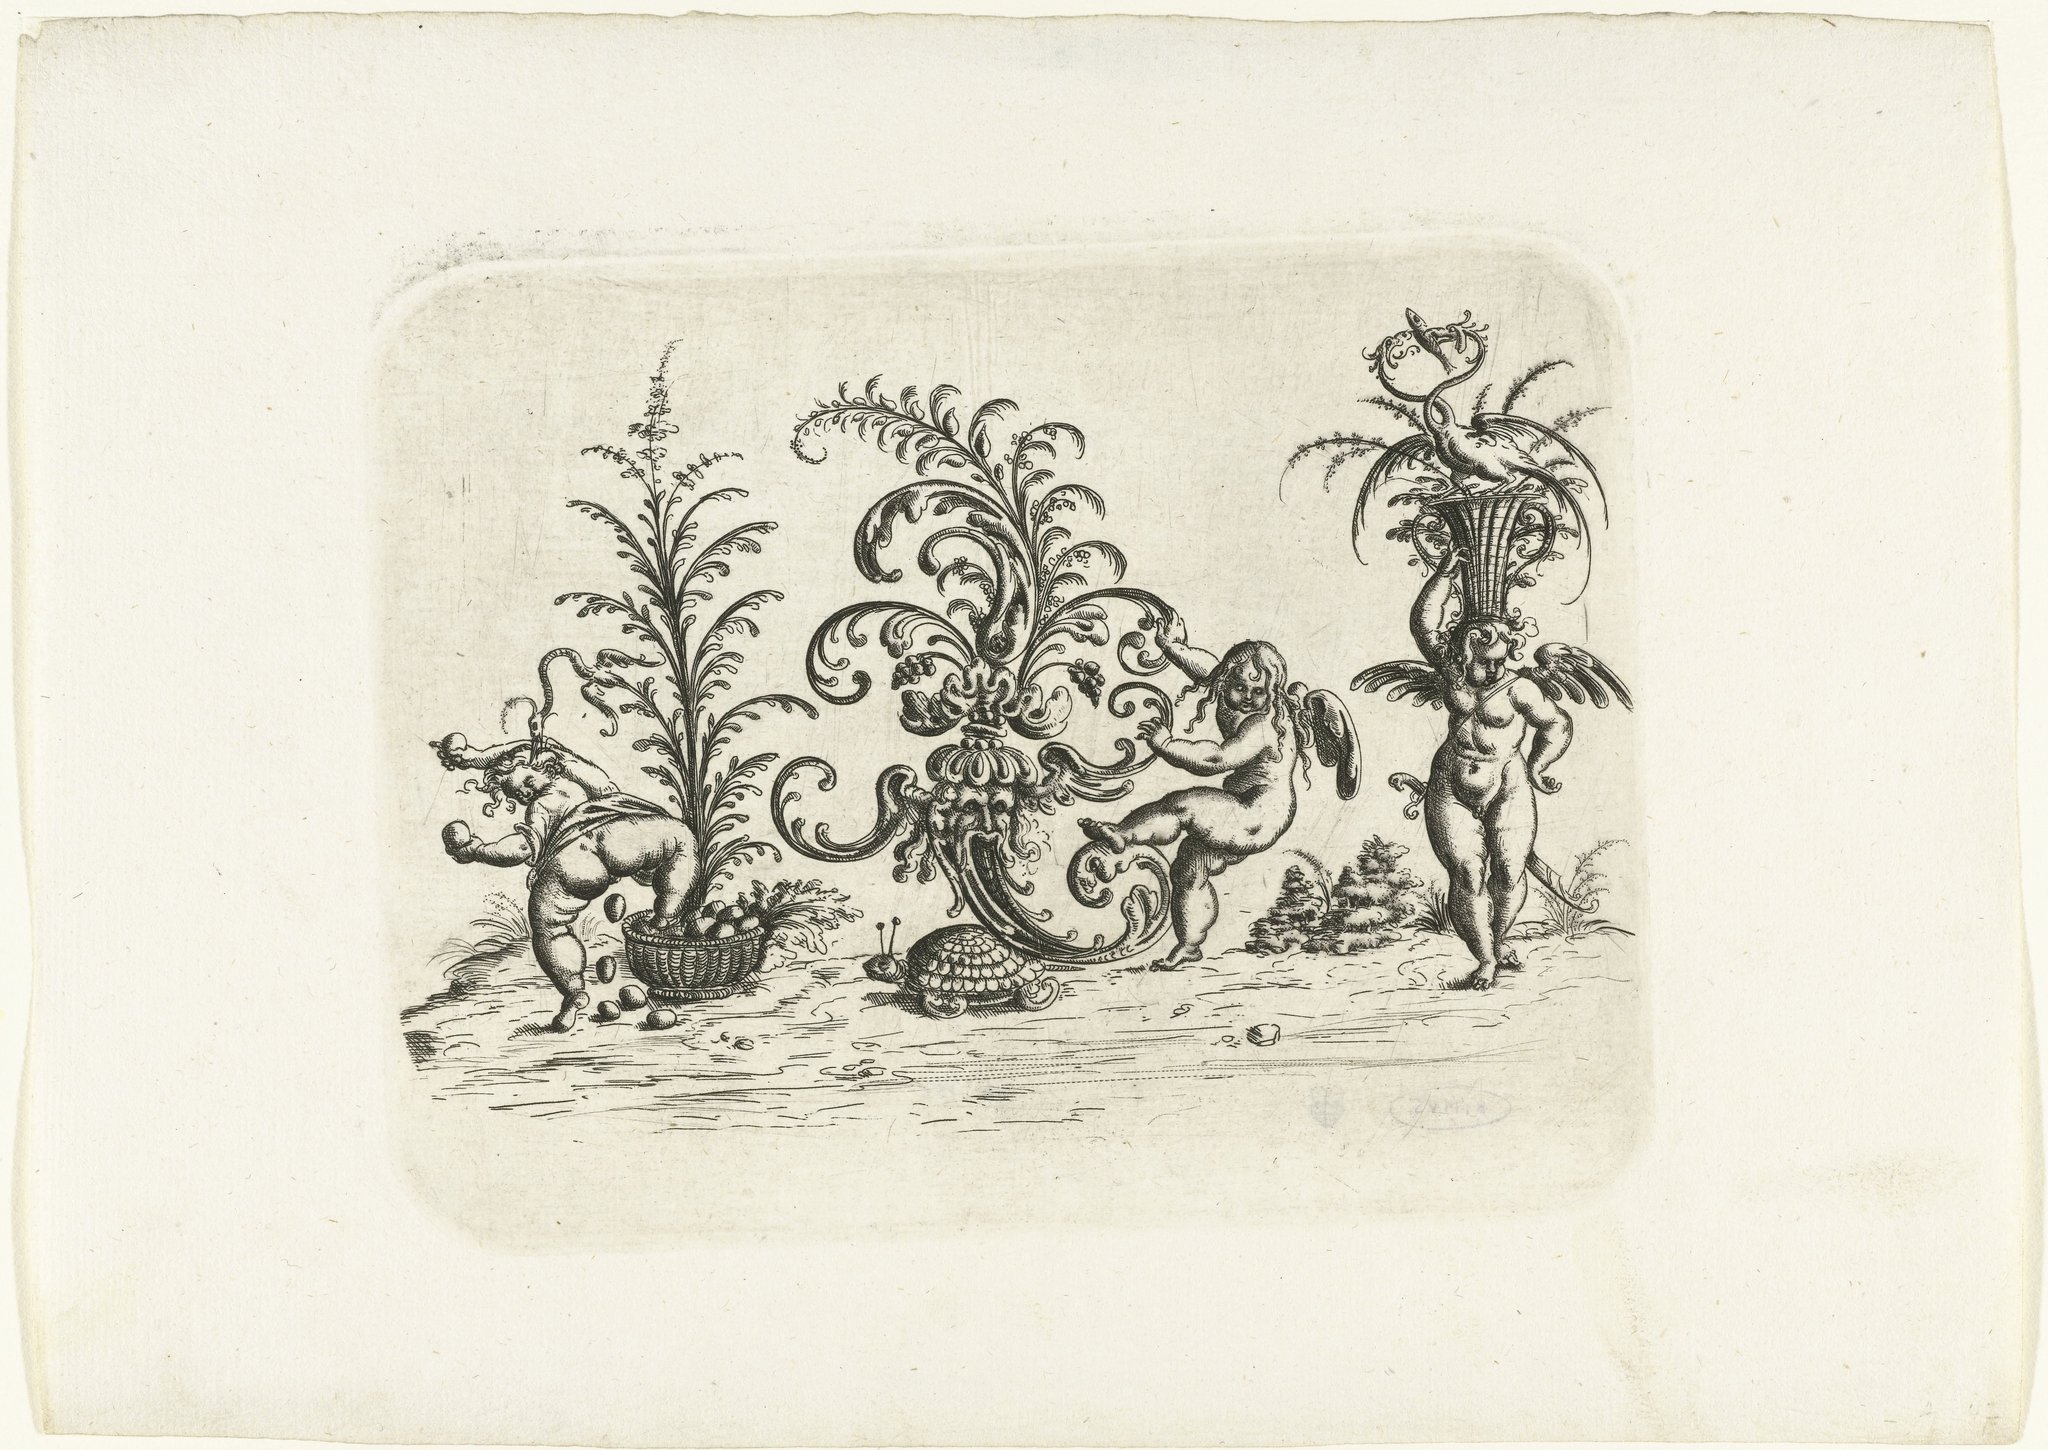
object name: print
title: Das Neuw Grottesken Buch Nürnberg 1610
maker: christoph jamnitzer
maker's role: draughtsman, goldsmith, print maker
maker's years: 1563-1618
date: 1573-1610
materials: paper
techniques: etching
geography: germany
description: Links een putto op de rug gezien, die met zijn hiel eieren uit een mand wipt. Blad uit een serie vlakdecoraties met grotesken, cartouches, ovalen, mascarons, putti en fantastische wezens. De serie bestaat uit drie titelbladen, twee tekstbladen met de opdracht en het voorwoord en 60 bladen, verdeeld over drie boeken.